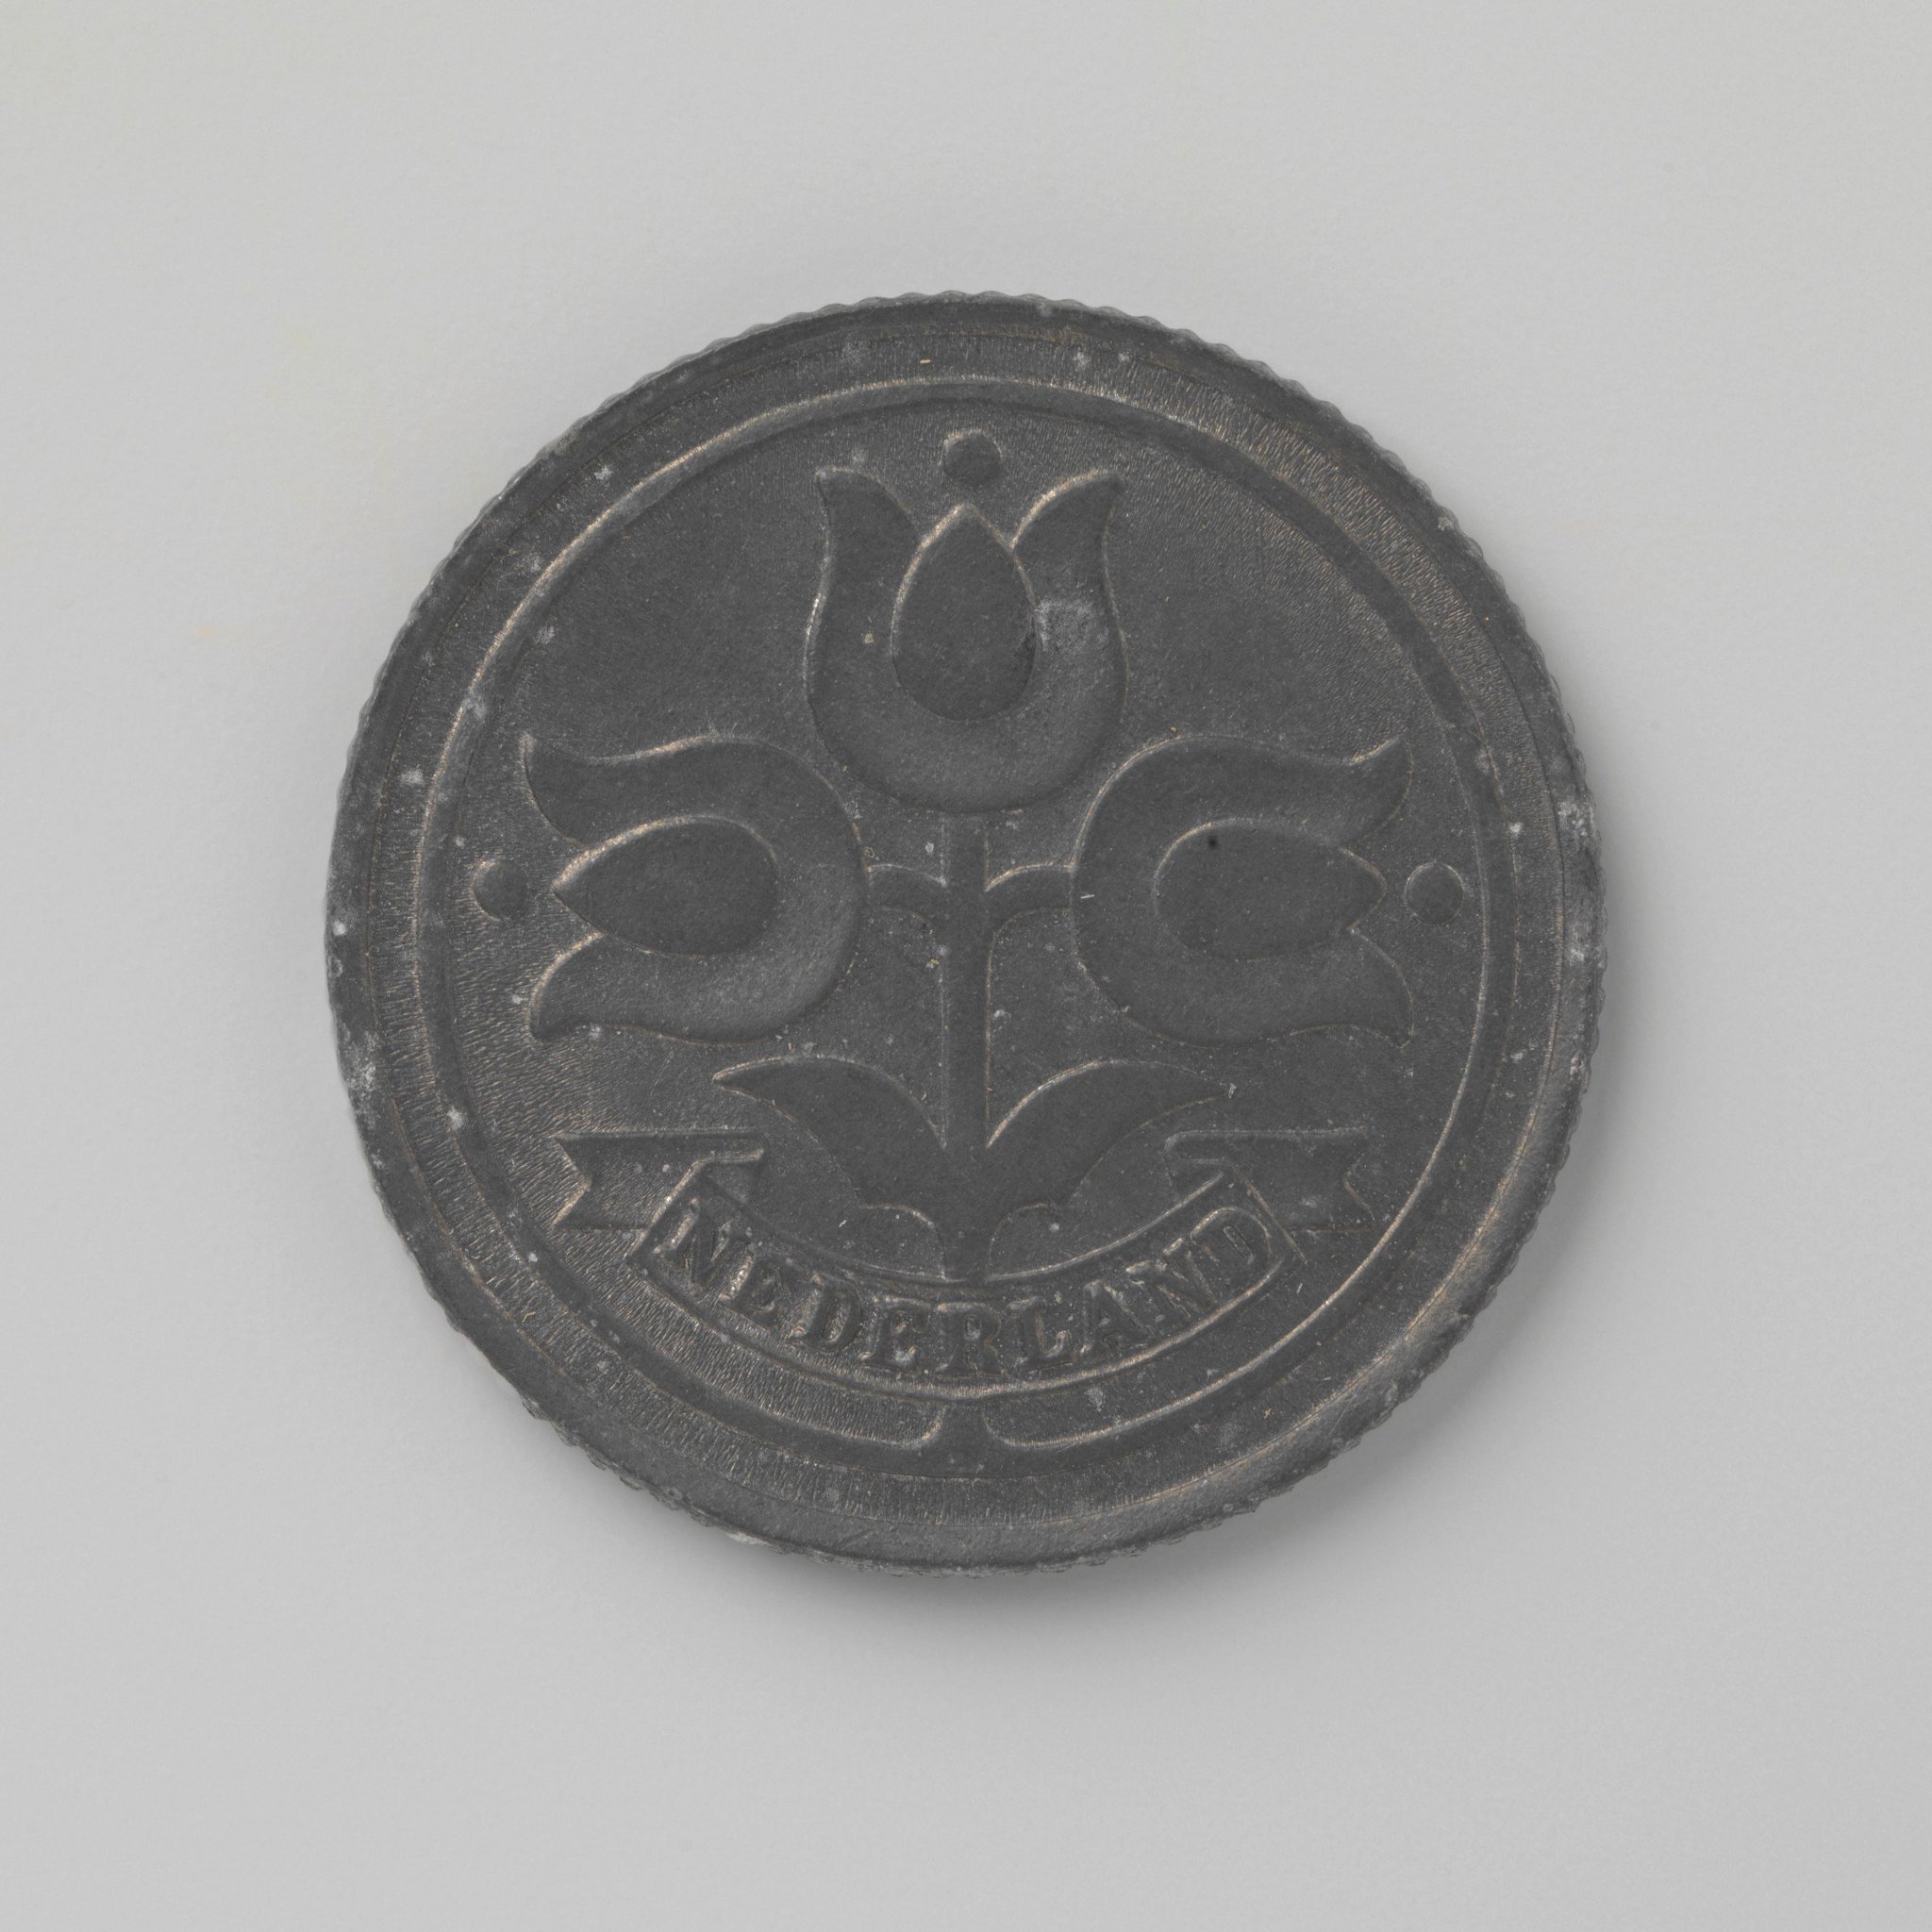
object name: coin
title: Nederland,10 cent,1941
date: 1941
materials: zinc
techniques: striking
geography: utrecht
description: Zinken munt. Voorzijde: drie gestyleerde tulpen. Keerzijde: tussen twee twijgen waarde-aanduiding 10 cents, waaronder jaartal. Kartelrand.